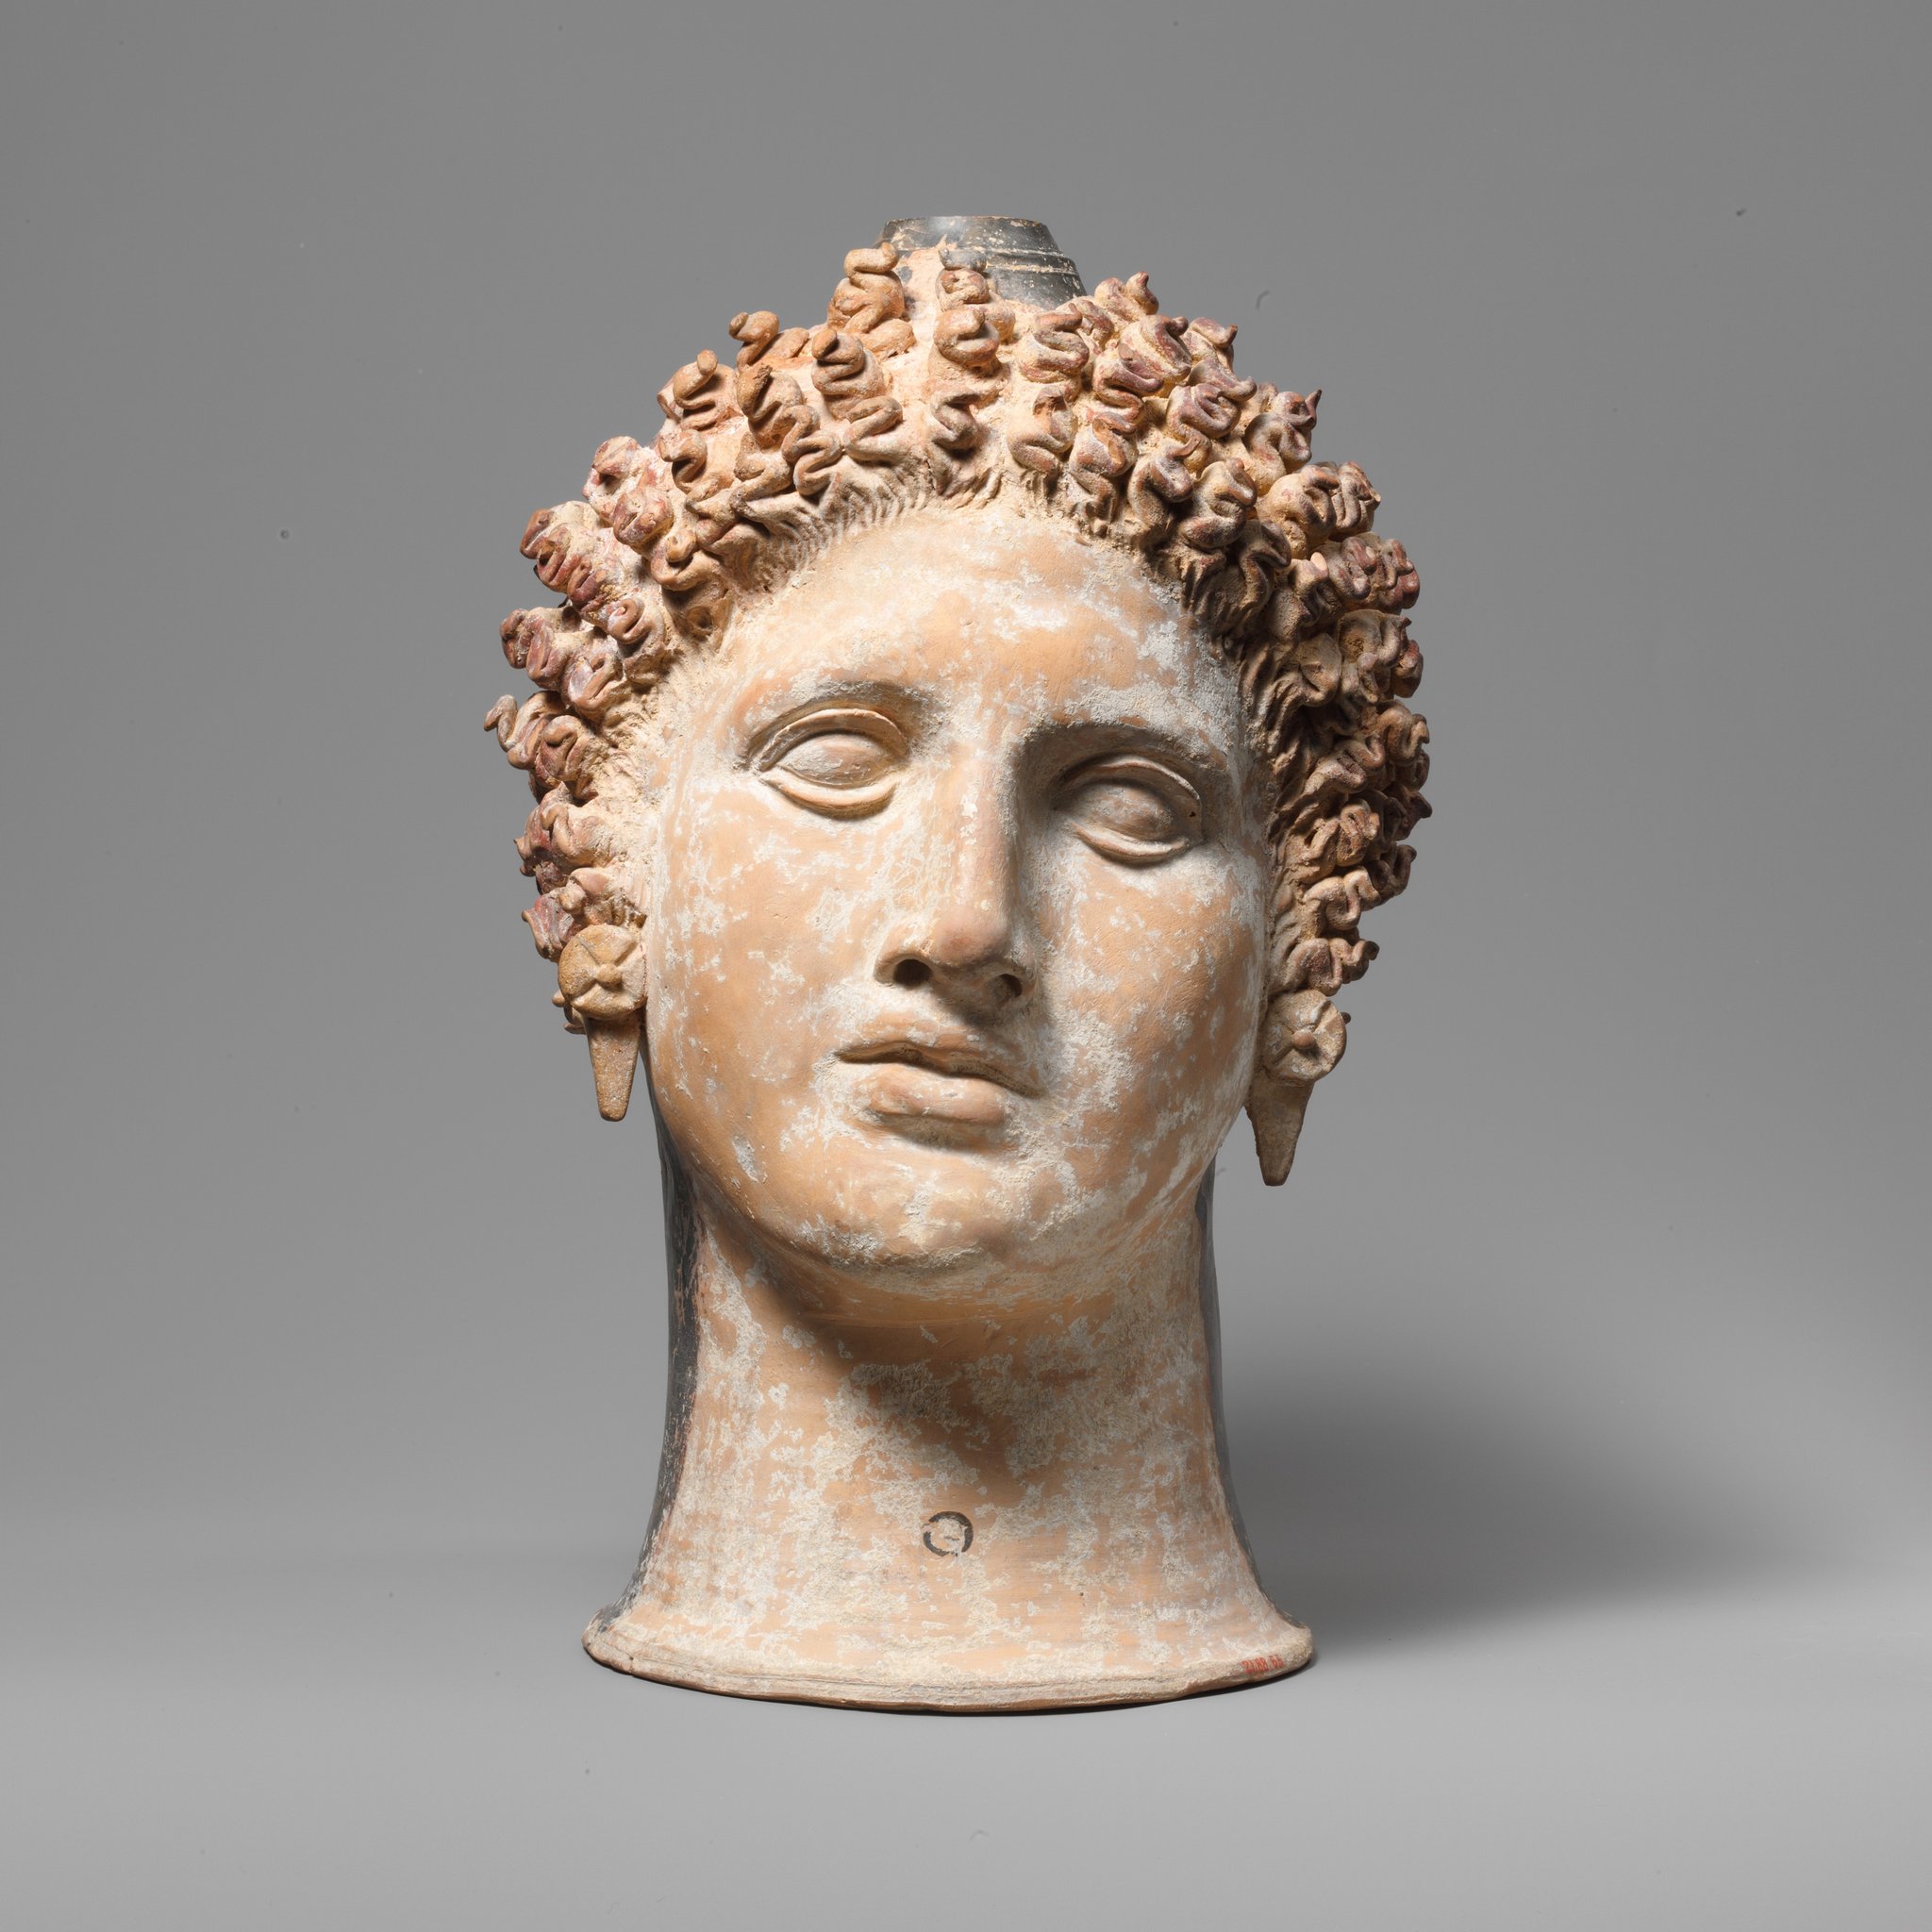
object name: lekythos in the form of a female head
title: Terracotta lekythos (oil flask)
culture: greek, south italian, apulian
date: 400-375 BCE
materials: terracotta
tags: heads,women